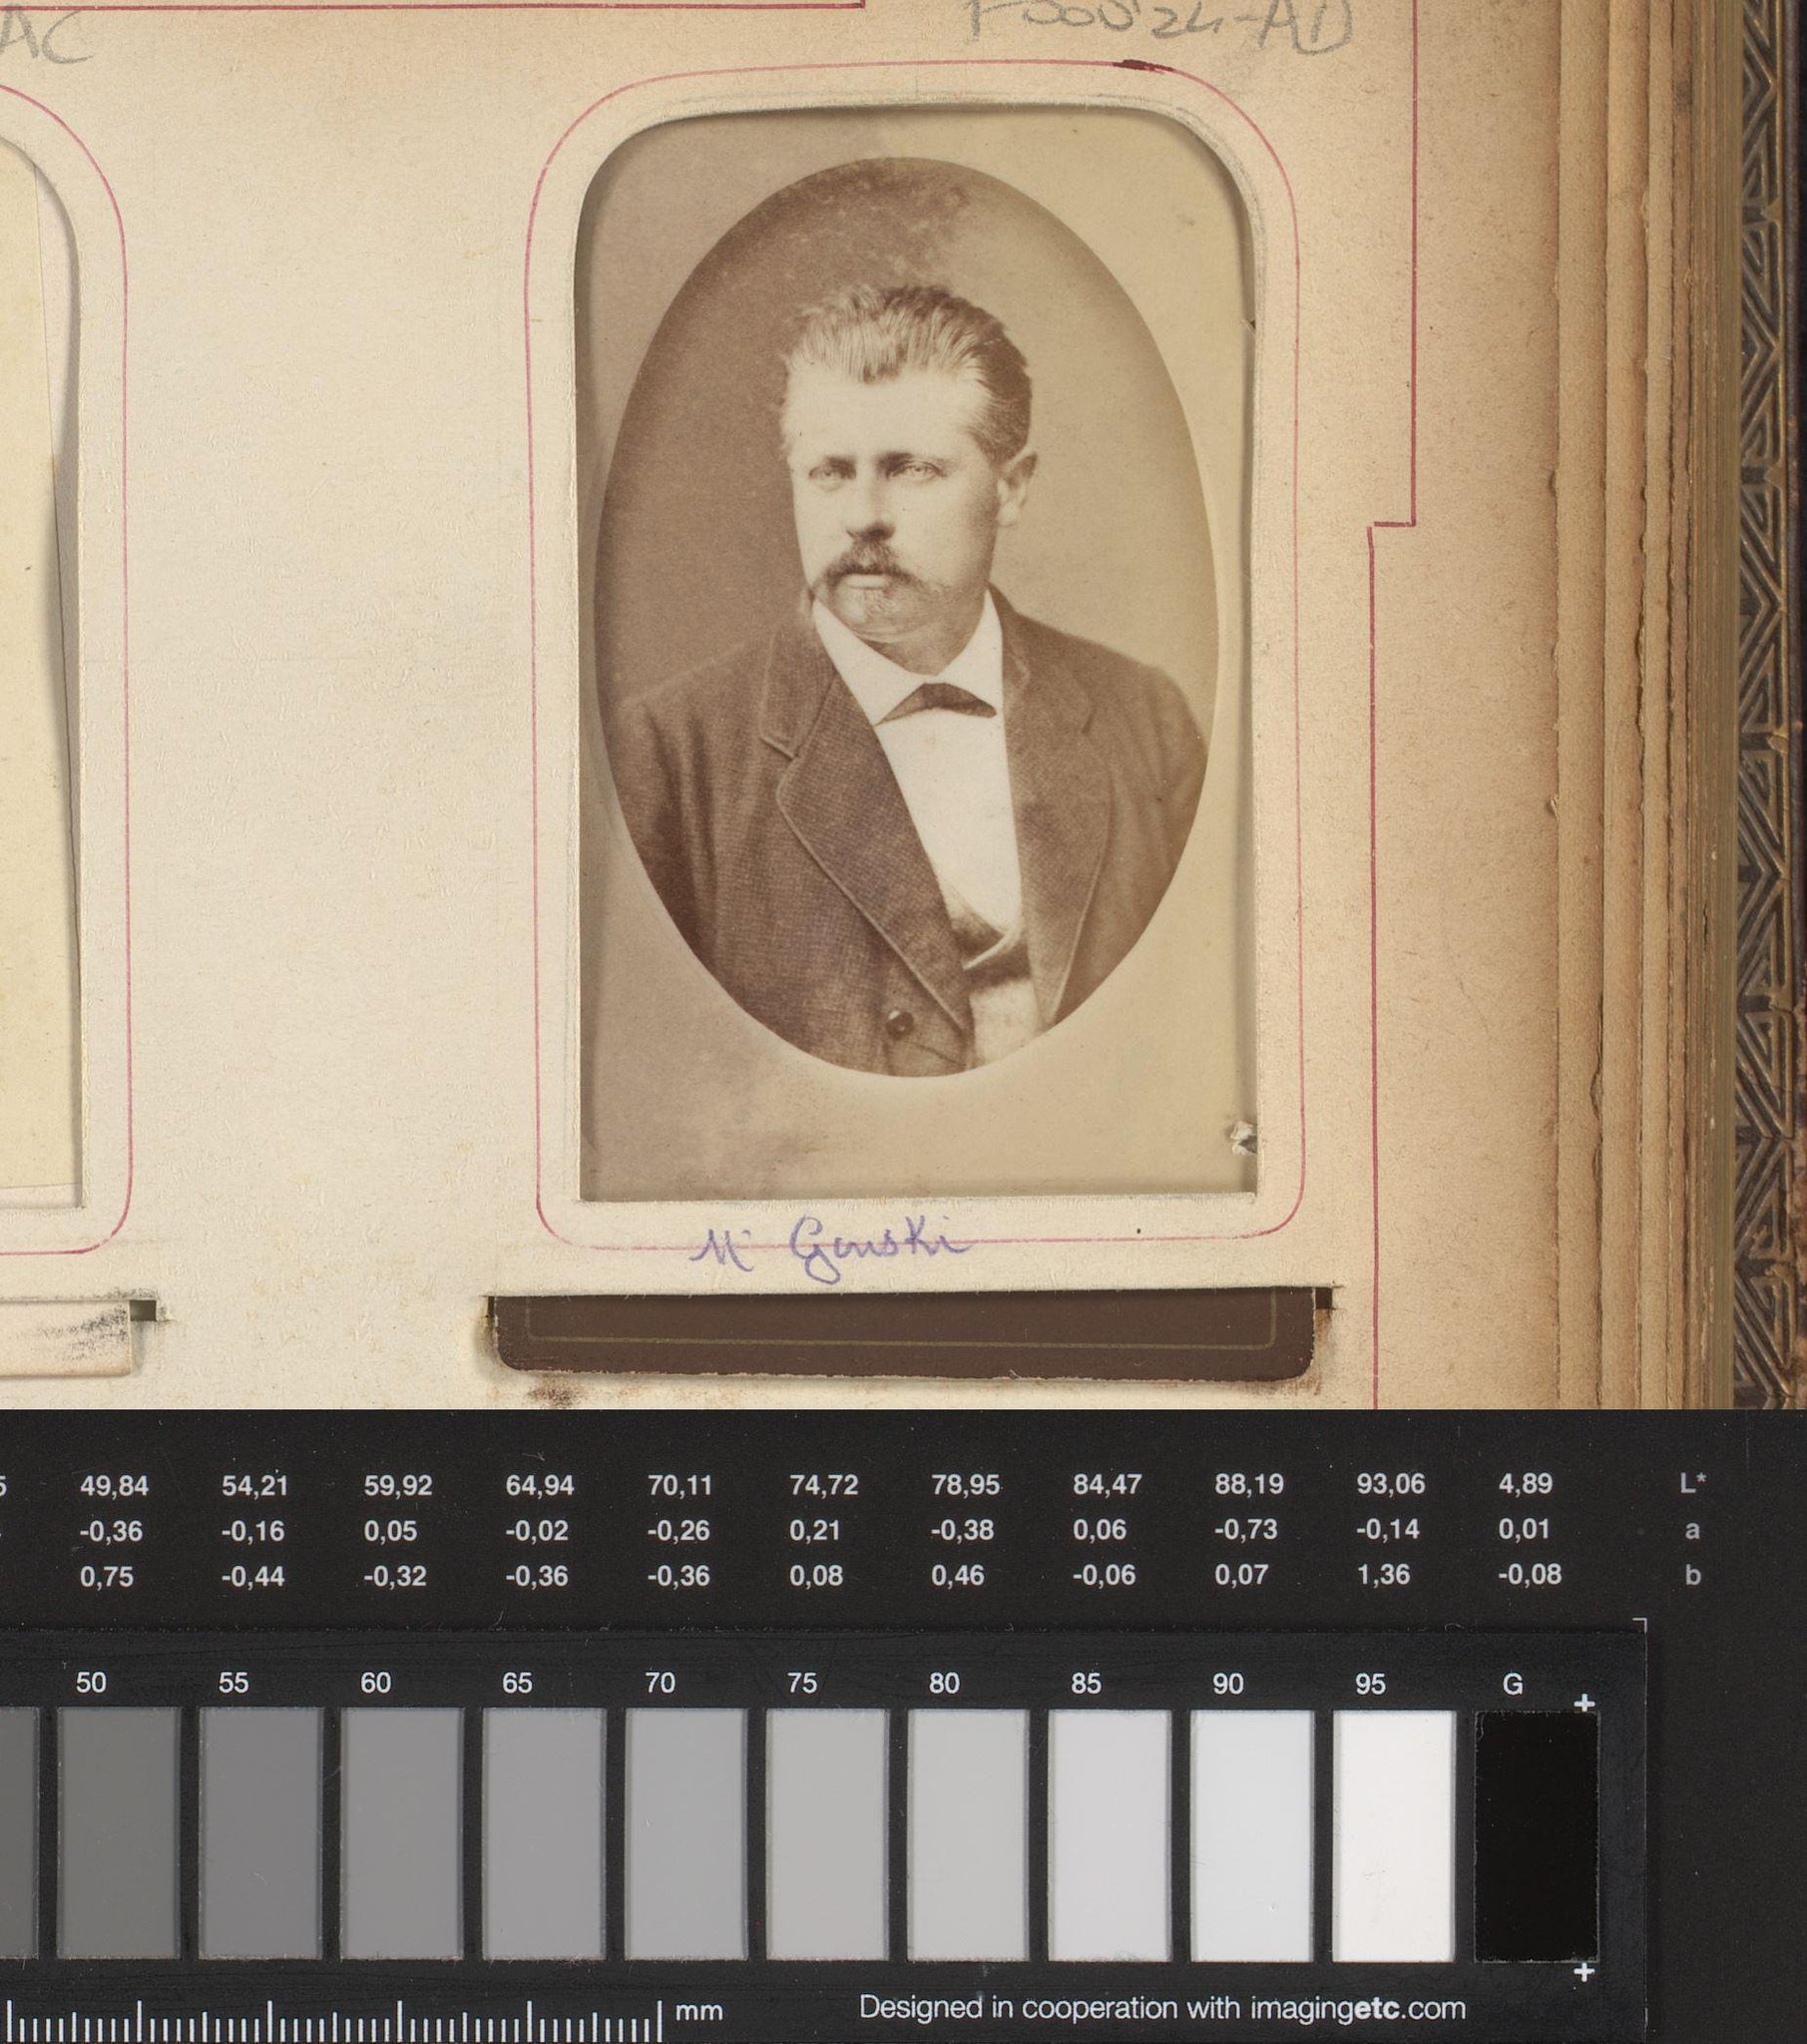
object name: album leaf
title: Portret van een man, aangeduid als Mr. Gouski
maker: louis martin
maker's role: fotograaf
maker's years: -1925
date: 1870-1900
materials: cardboard, celluloid, paper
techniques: albumen print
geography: nantes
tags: adult man, anonymous historical person portrayed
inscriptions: address: ‘12 Rue Boileau/ NANTES’, inscription: ‘Les Clichés sont conservés’